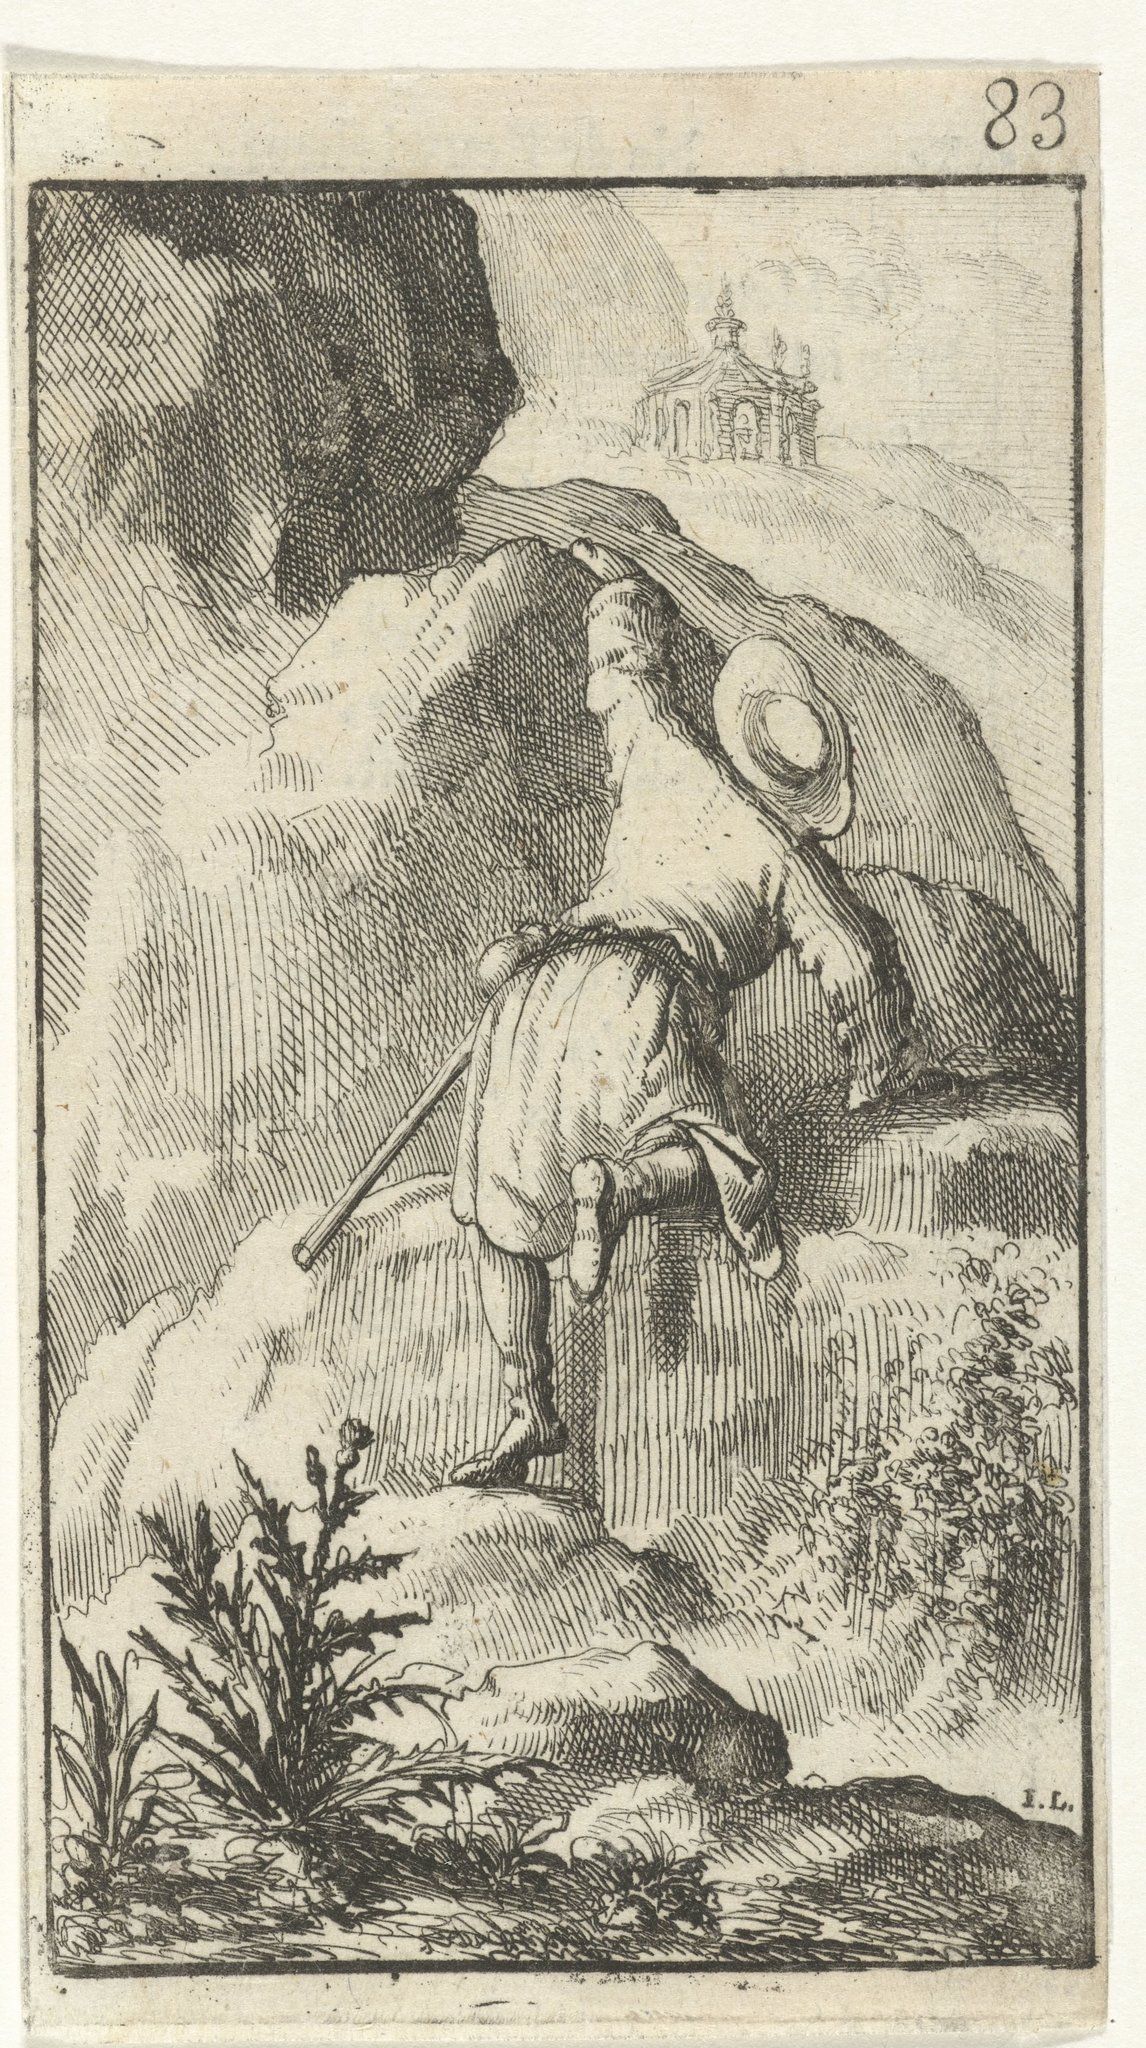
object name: print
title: Christen beklimt de heuvel Moeilijkheid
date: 1684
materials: paper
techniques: etching, letterpress printing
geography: amsterdam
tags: mountain climbing, mountaineering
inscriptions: collector's mark: Lugt 2228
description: Illustratie uit: Bunyan, John. Eens christens reyse na de eeuwigheyt. Amsterdam: Johannes Boekholt, 1684.